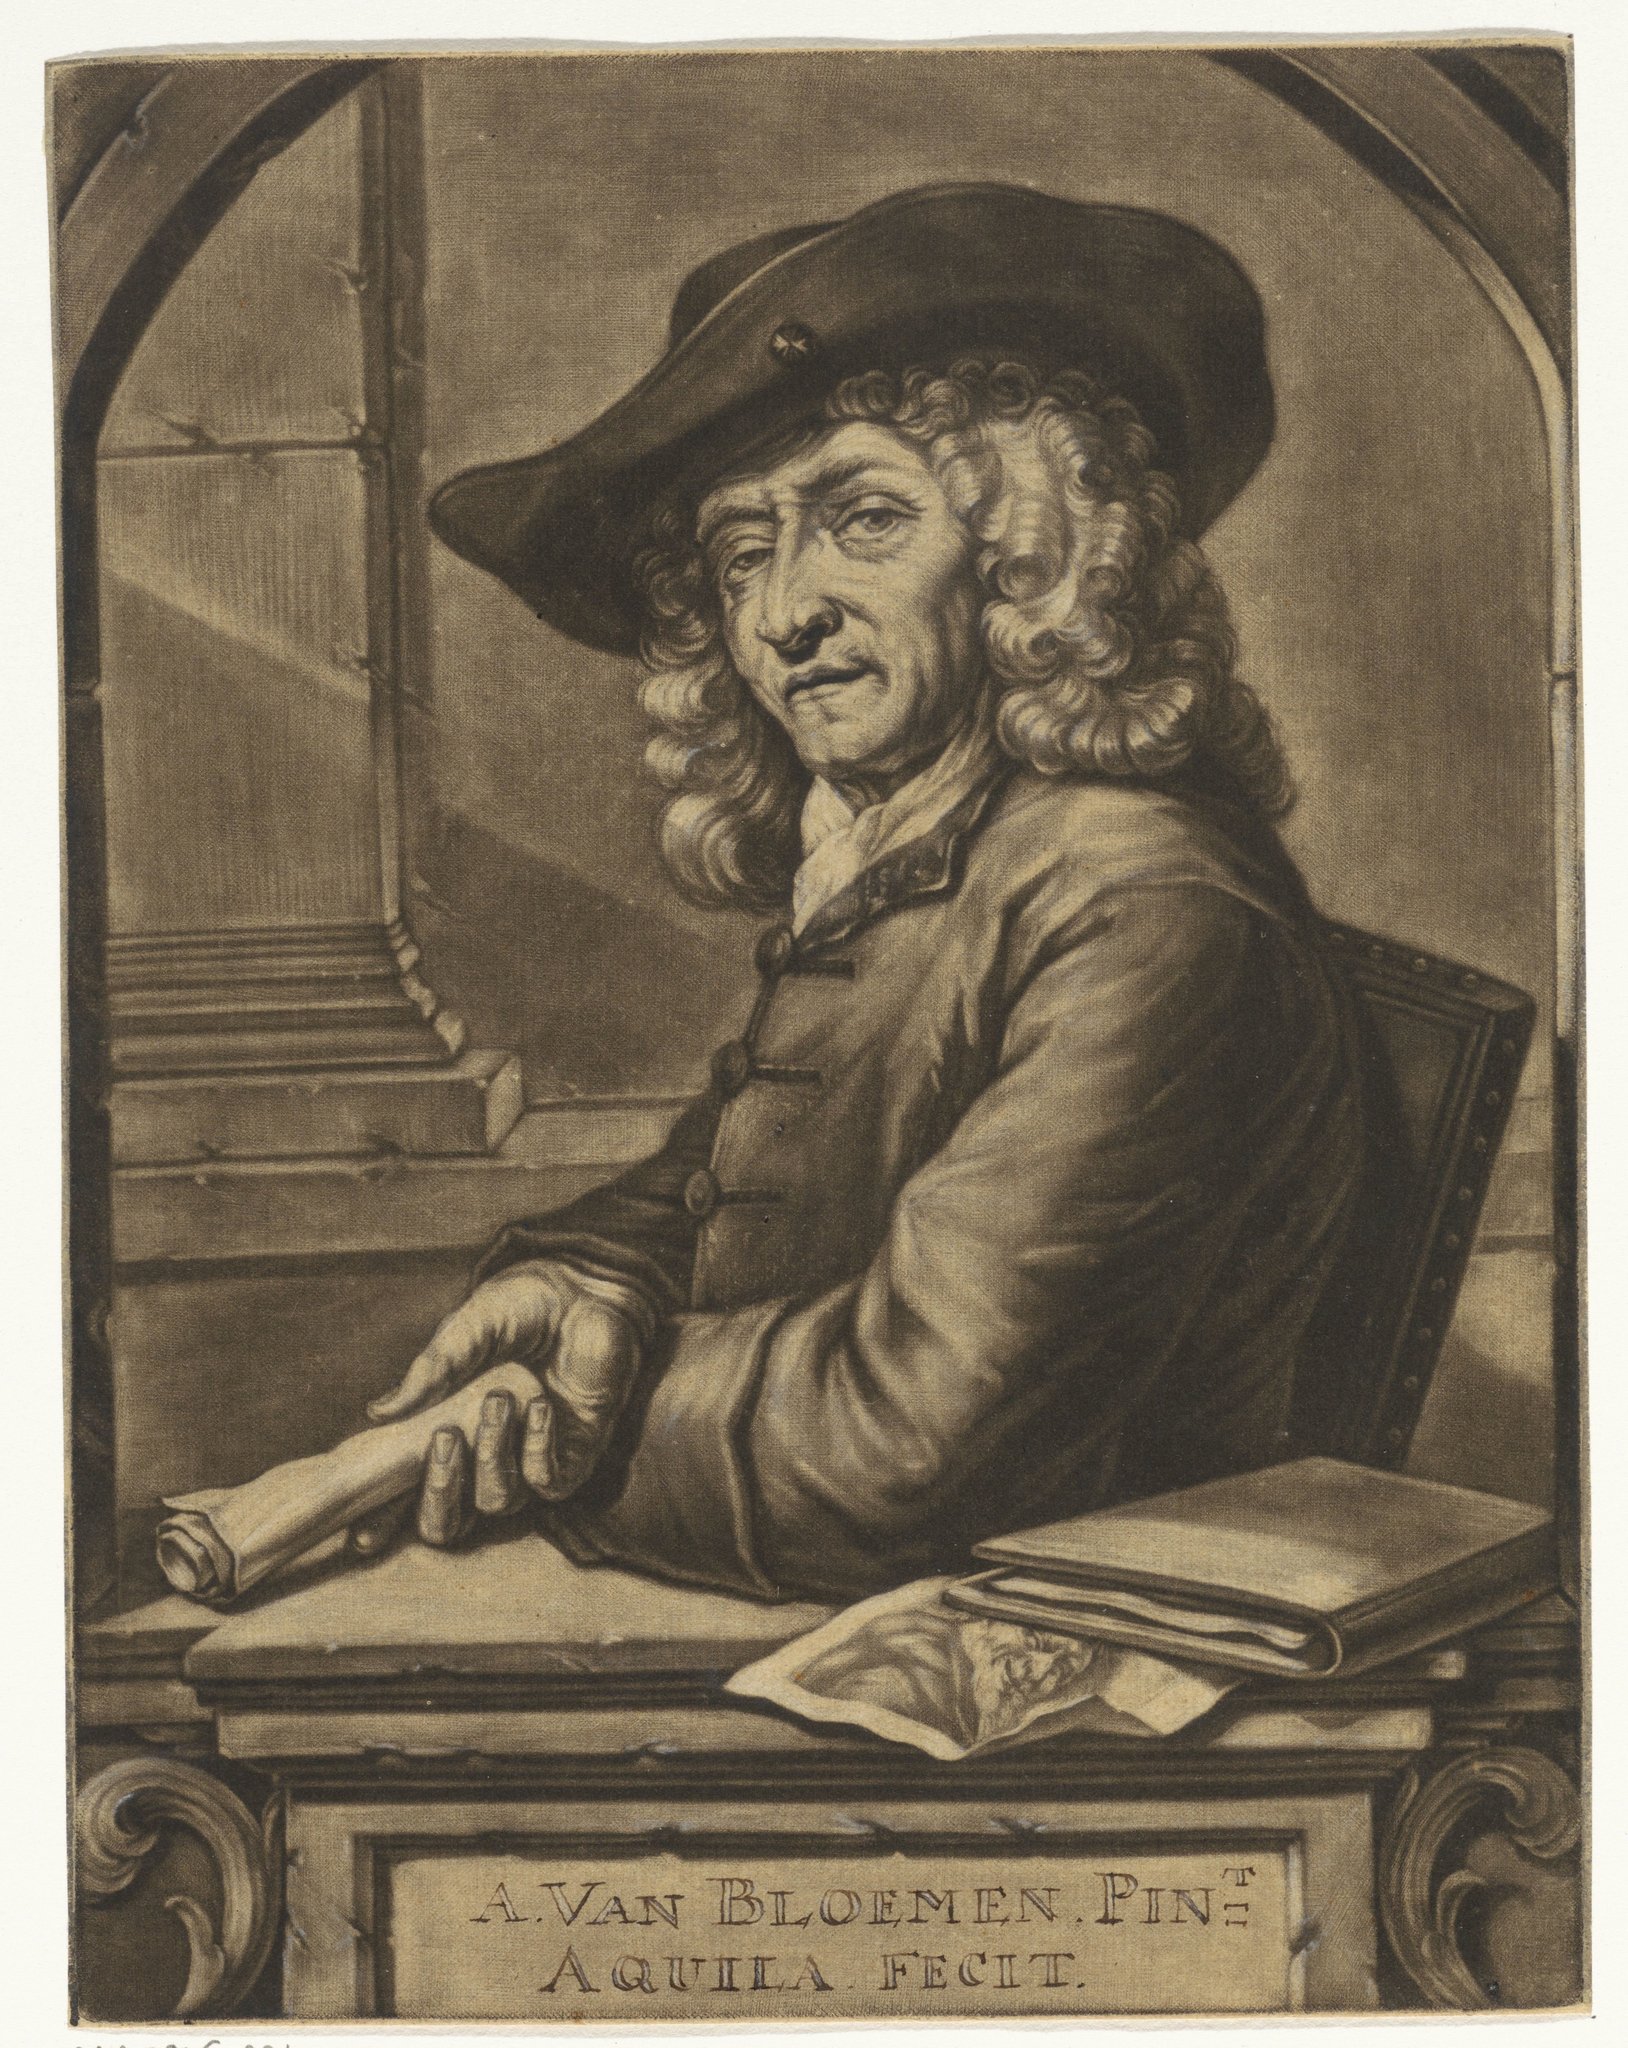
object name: print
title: Portret van Jan Pietersz. Zomer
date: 1717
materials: paint, paper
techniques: pen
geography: amsterdam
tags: amsterdam, draughtsman, jan pietersz. zomer, print, e.g.: engraving, etching, lithograph, (story of) democritus, the philosopher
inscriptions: inscription: ‘A. Van Bloemen Pint / Aquila Fecit.’, collector's mark: Lugt 2228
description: De Amsterdamse kunsthandelaar Jan Pietersz. Zomer met in de hand een opgerold vel. Naast hem een boek en een afbeelding van de lachende filosoof Democritus.